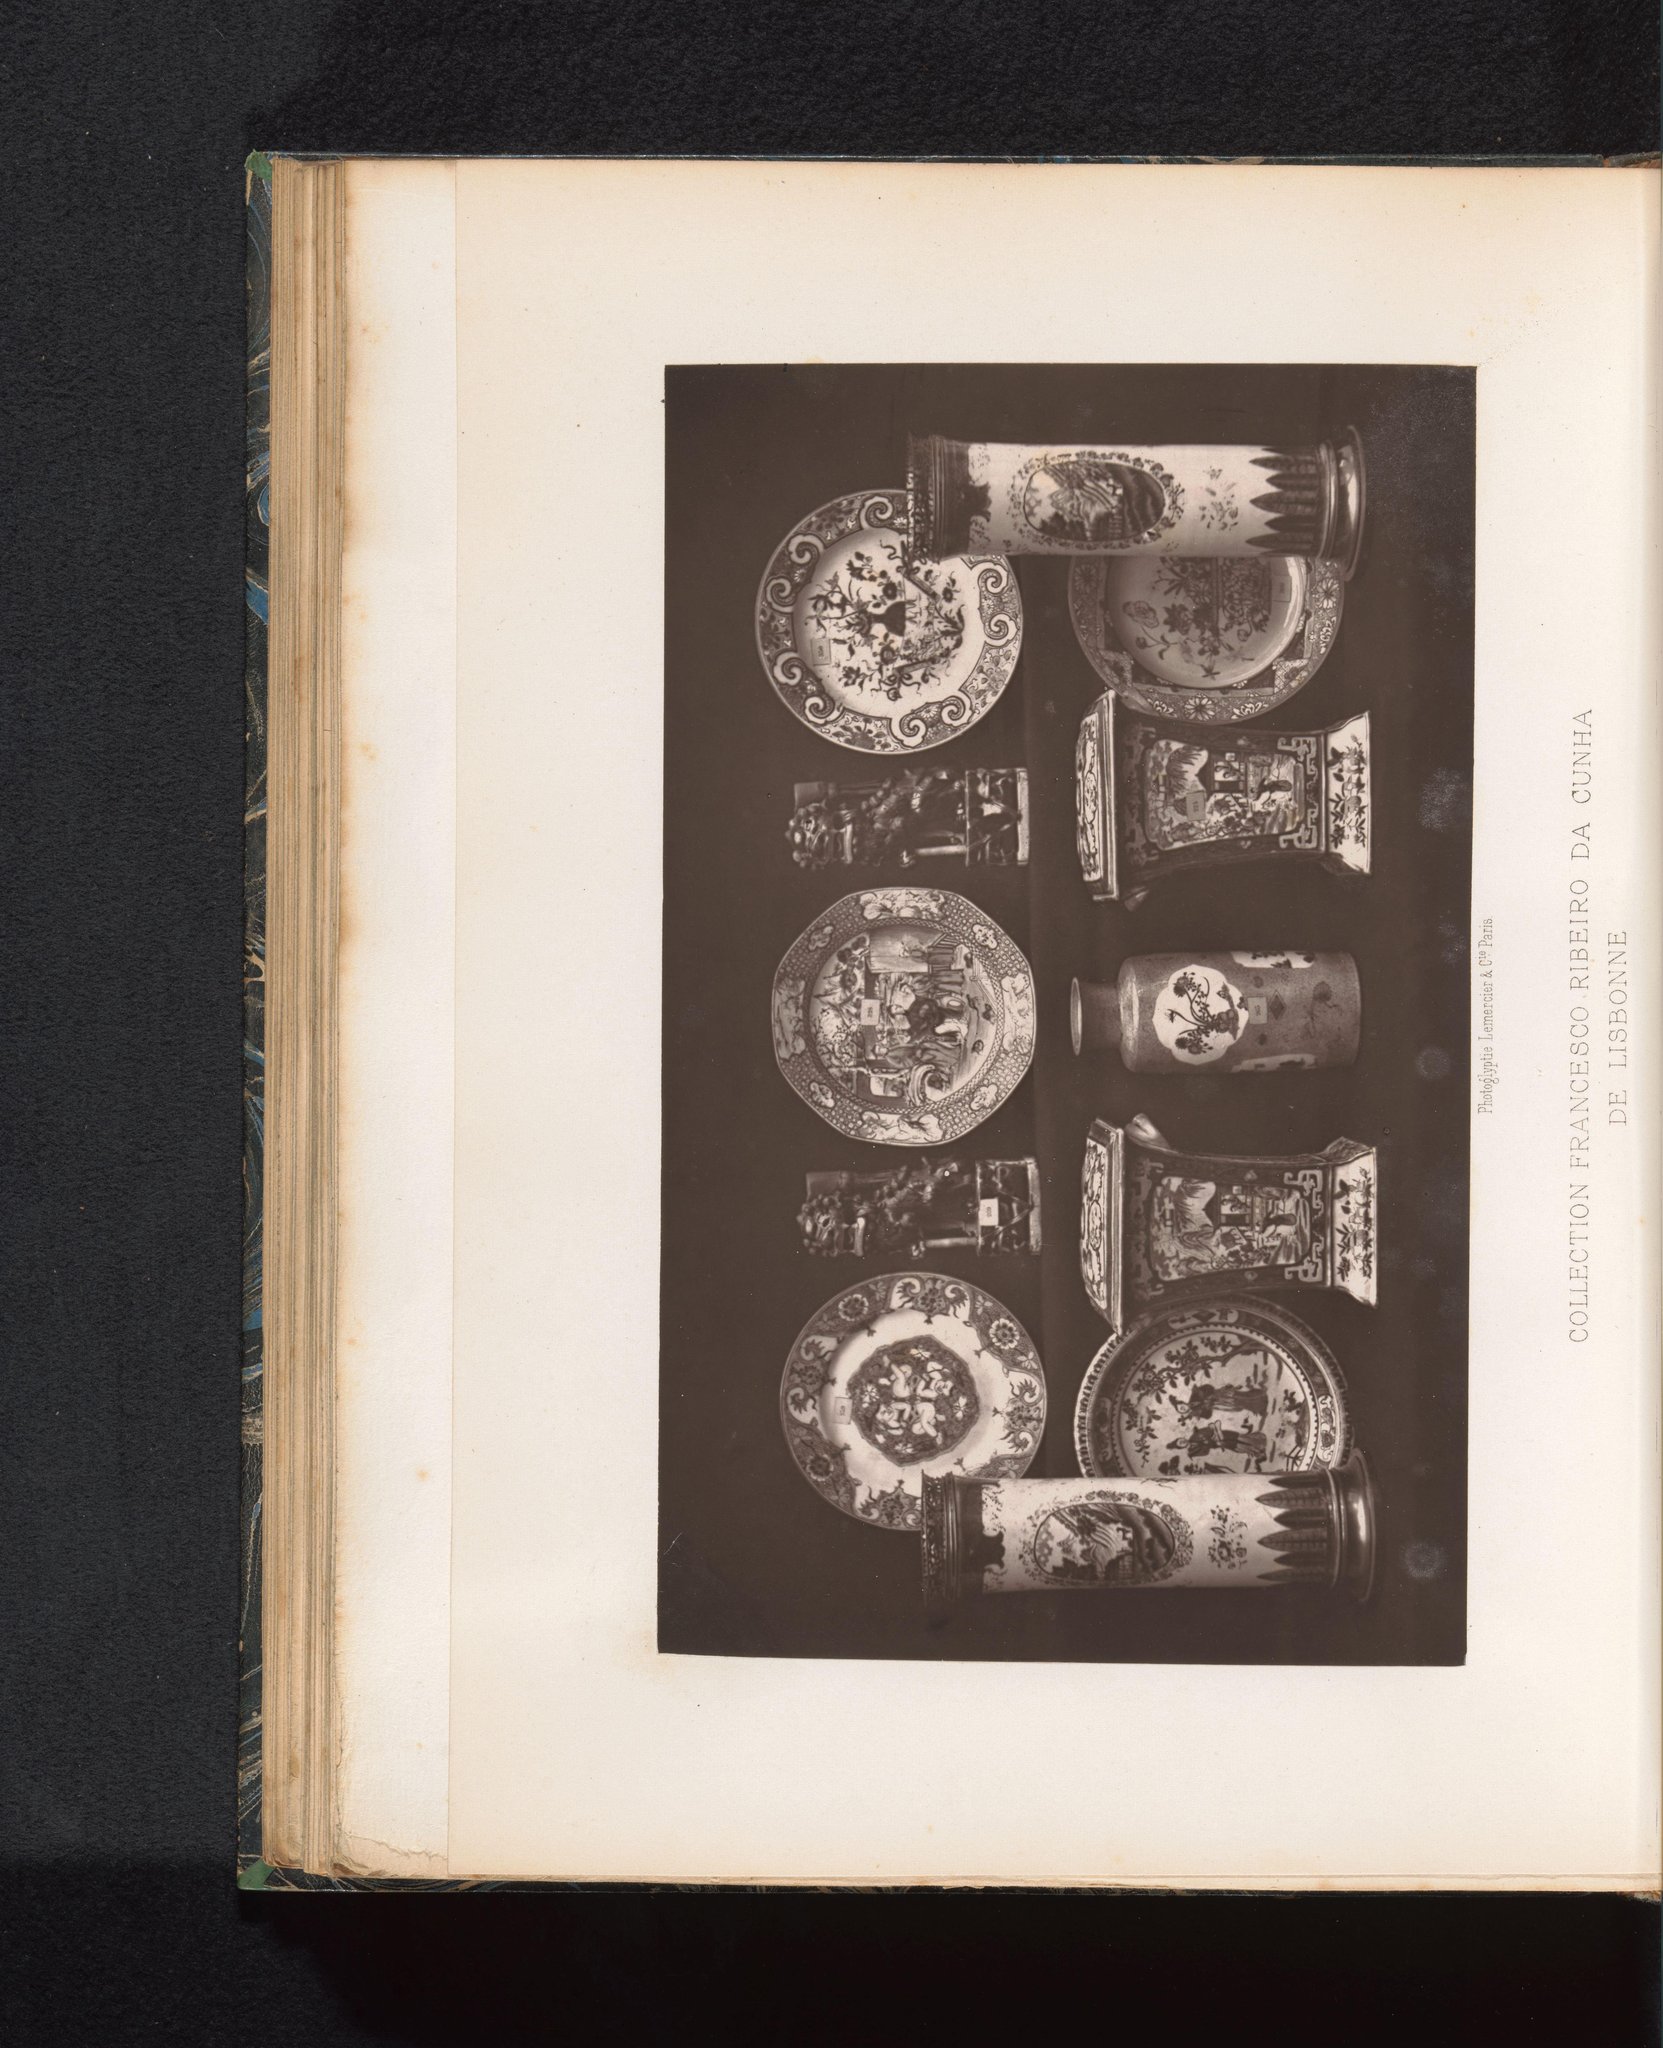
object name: page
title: Chinees porselein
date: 1879-1884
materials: paper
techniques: woodburytype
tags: container of ceramics: jar, jug, pot, vase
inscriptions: inscription: ‘Collection Francesco Riberio da Cunha de Lisbonne’